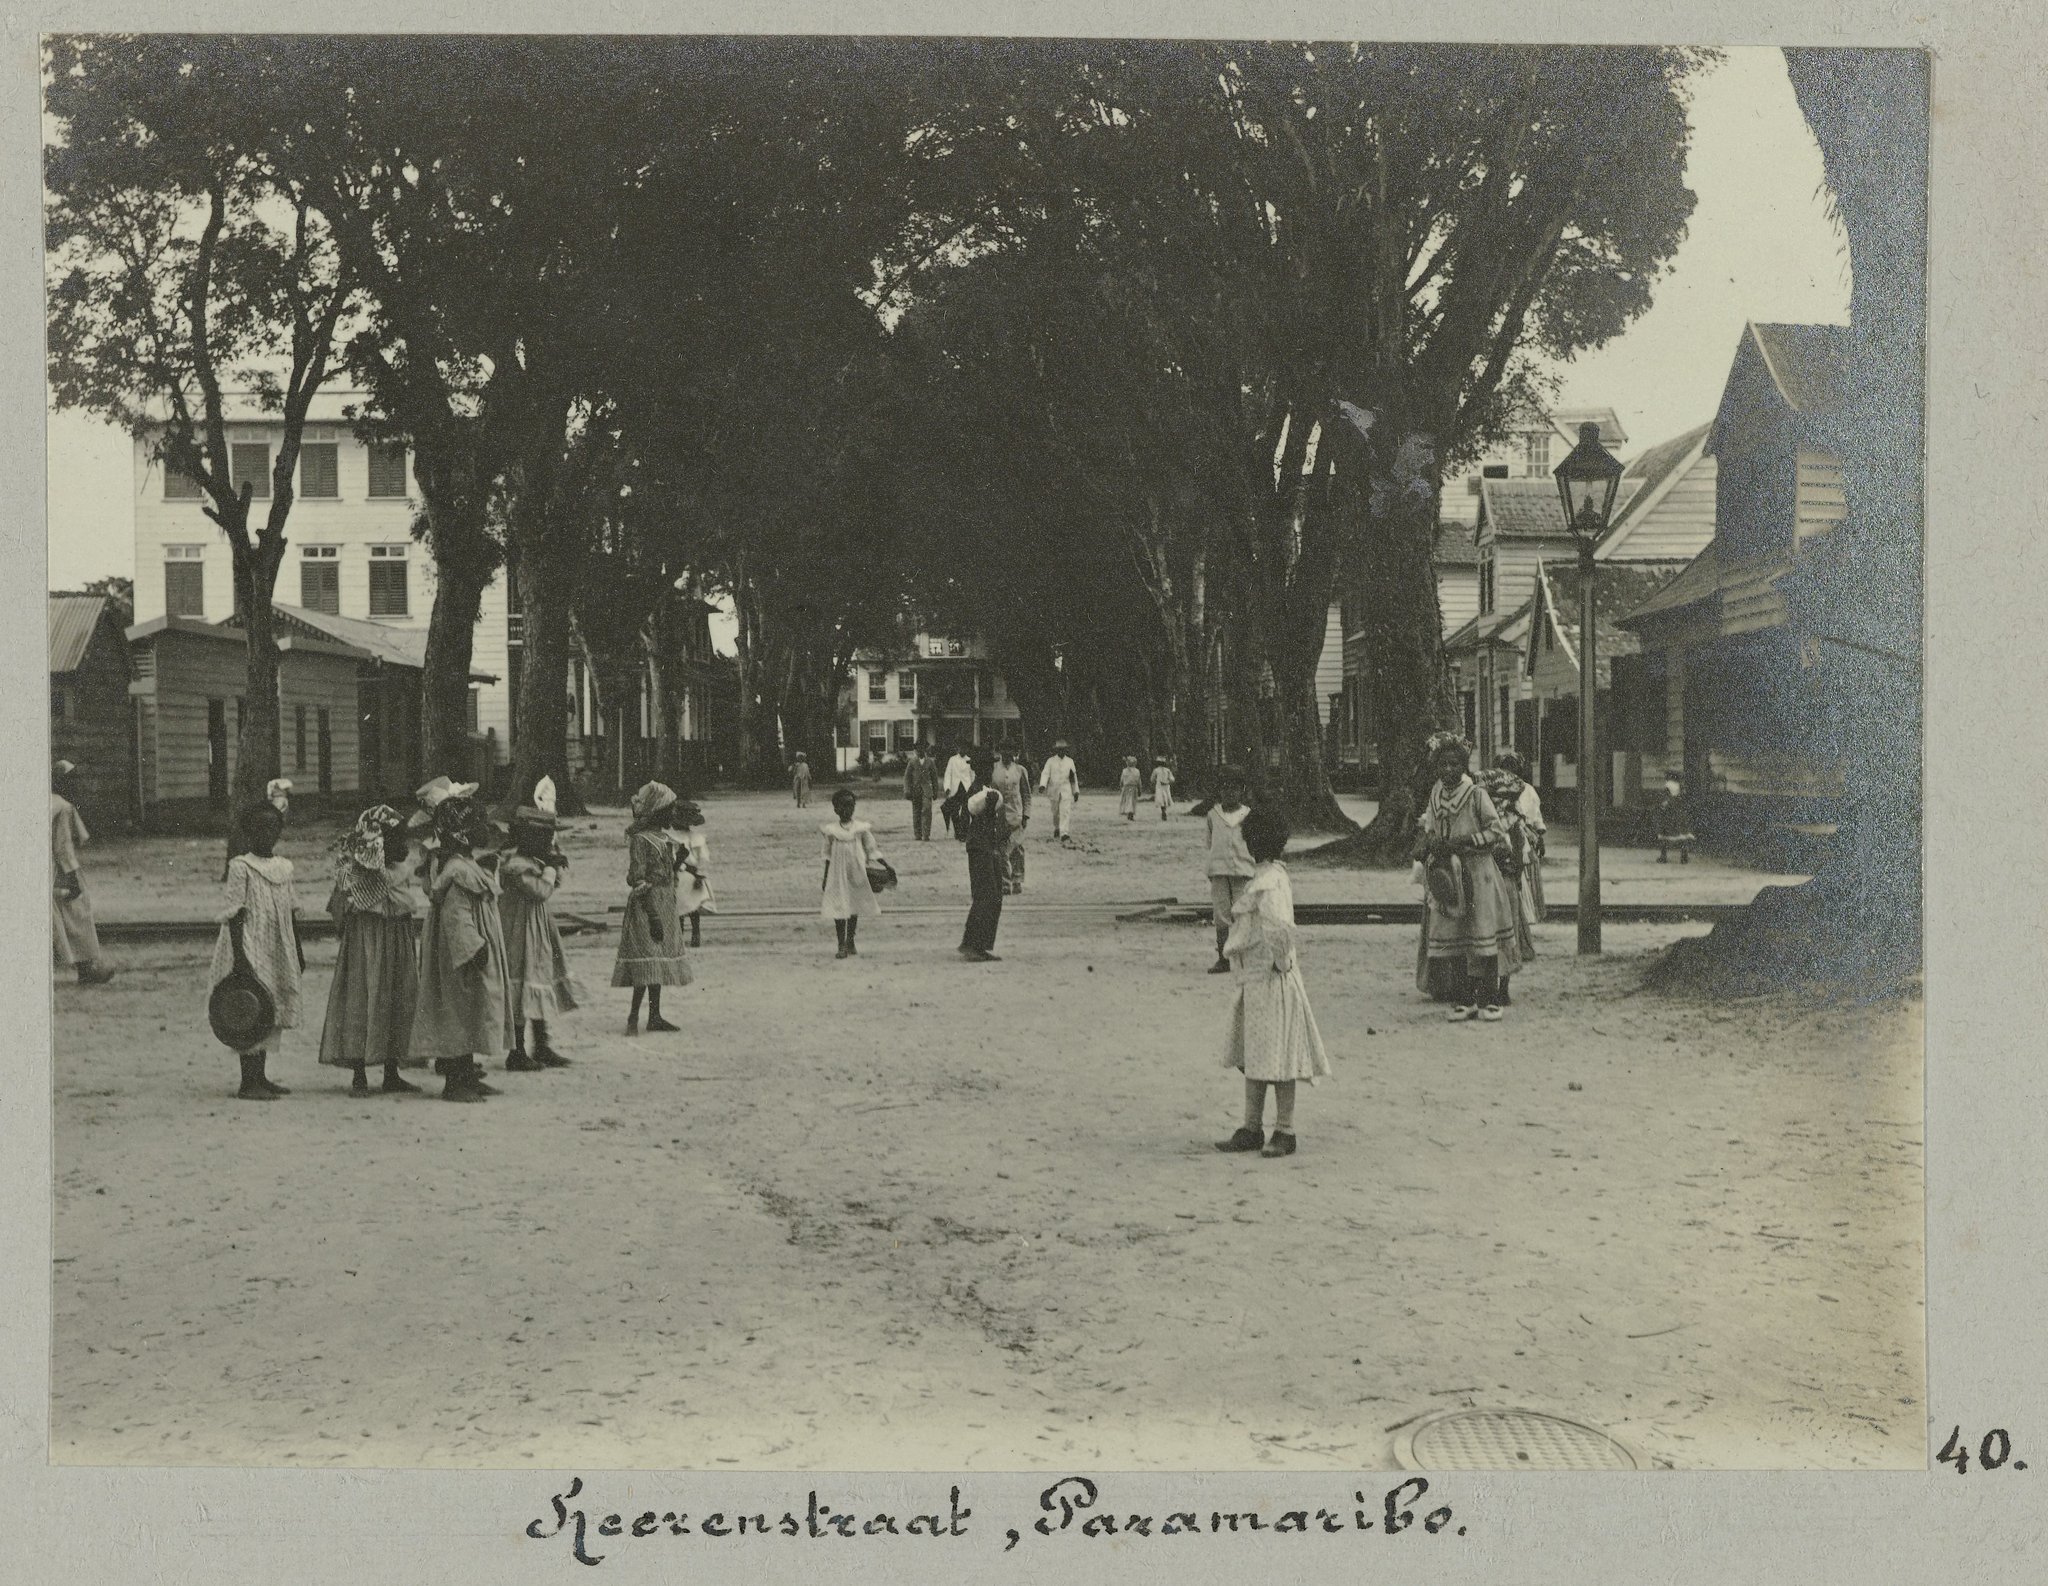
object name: photograph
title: Heerenstraat, Paramaribo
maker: hendrik doijer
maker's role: engineer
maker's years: 1863-1925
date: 1903-1910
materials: photographic support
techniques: gelatin silver print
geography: suriname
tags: suriname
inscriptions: inscription: ‘40. / Heerenstraat, Paramaribo.’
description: Gezicht in de Heerenstraat te Paramaribo, op de voorgrond een groep meisjes. Onderdeel van het fotoalbum Souvenir de Voyage (deel 2), over het leven van de familie Doijer in en rond de plantage Ma Retraite in Suriname in de jaren 1903-1910.